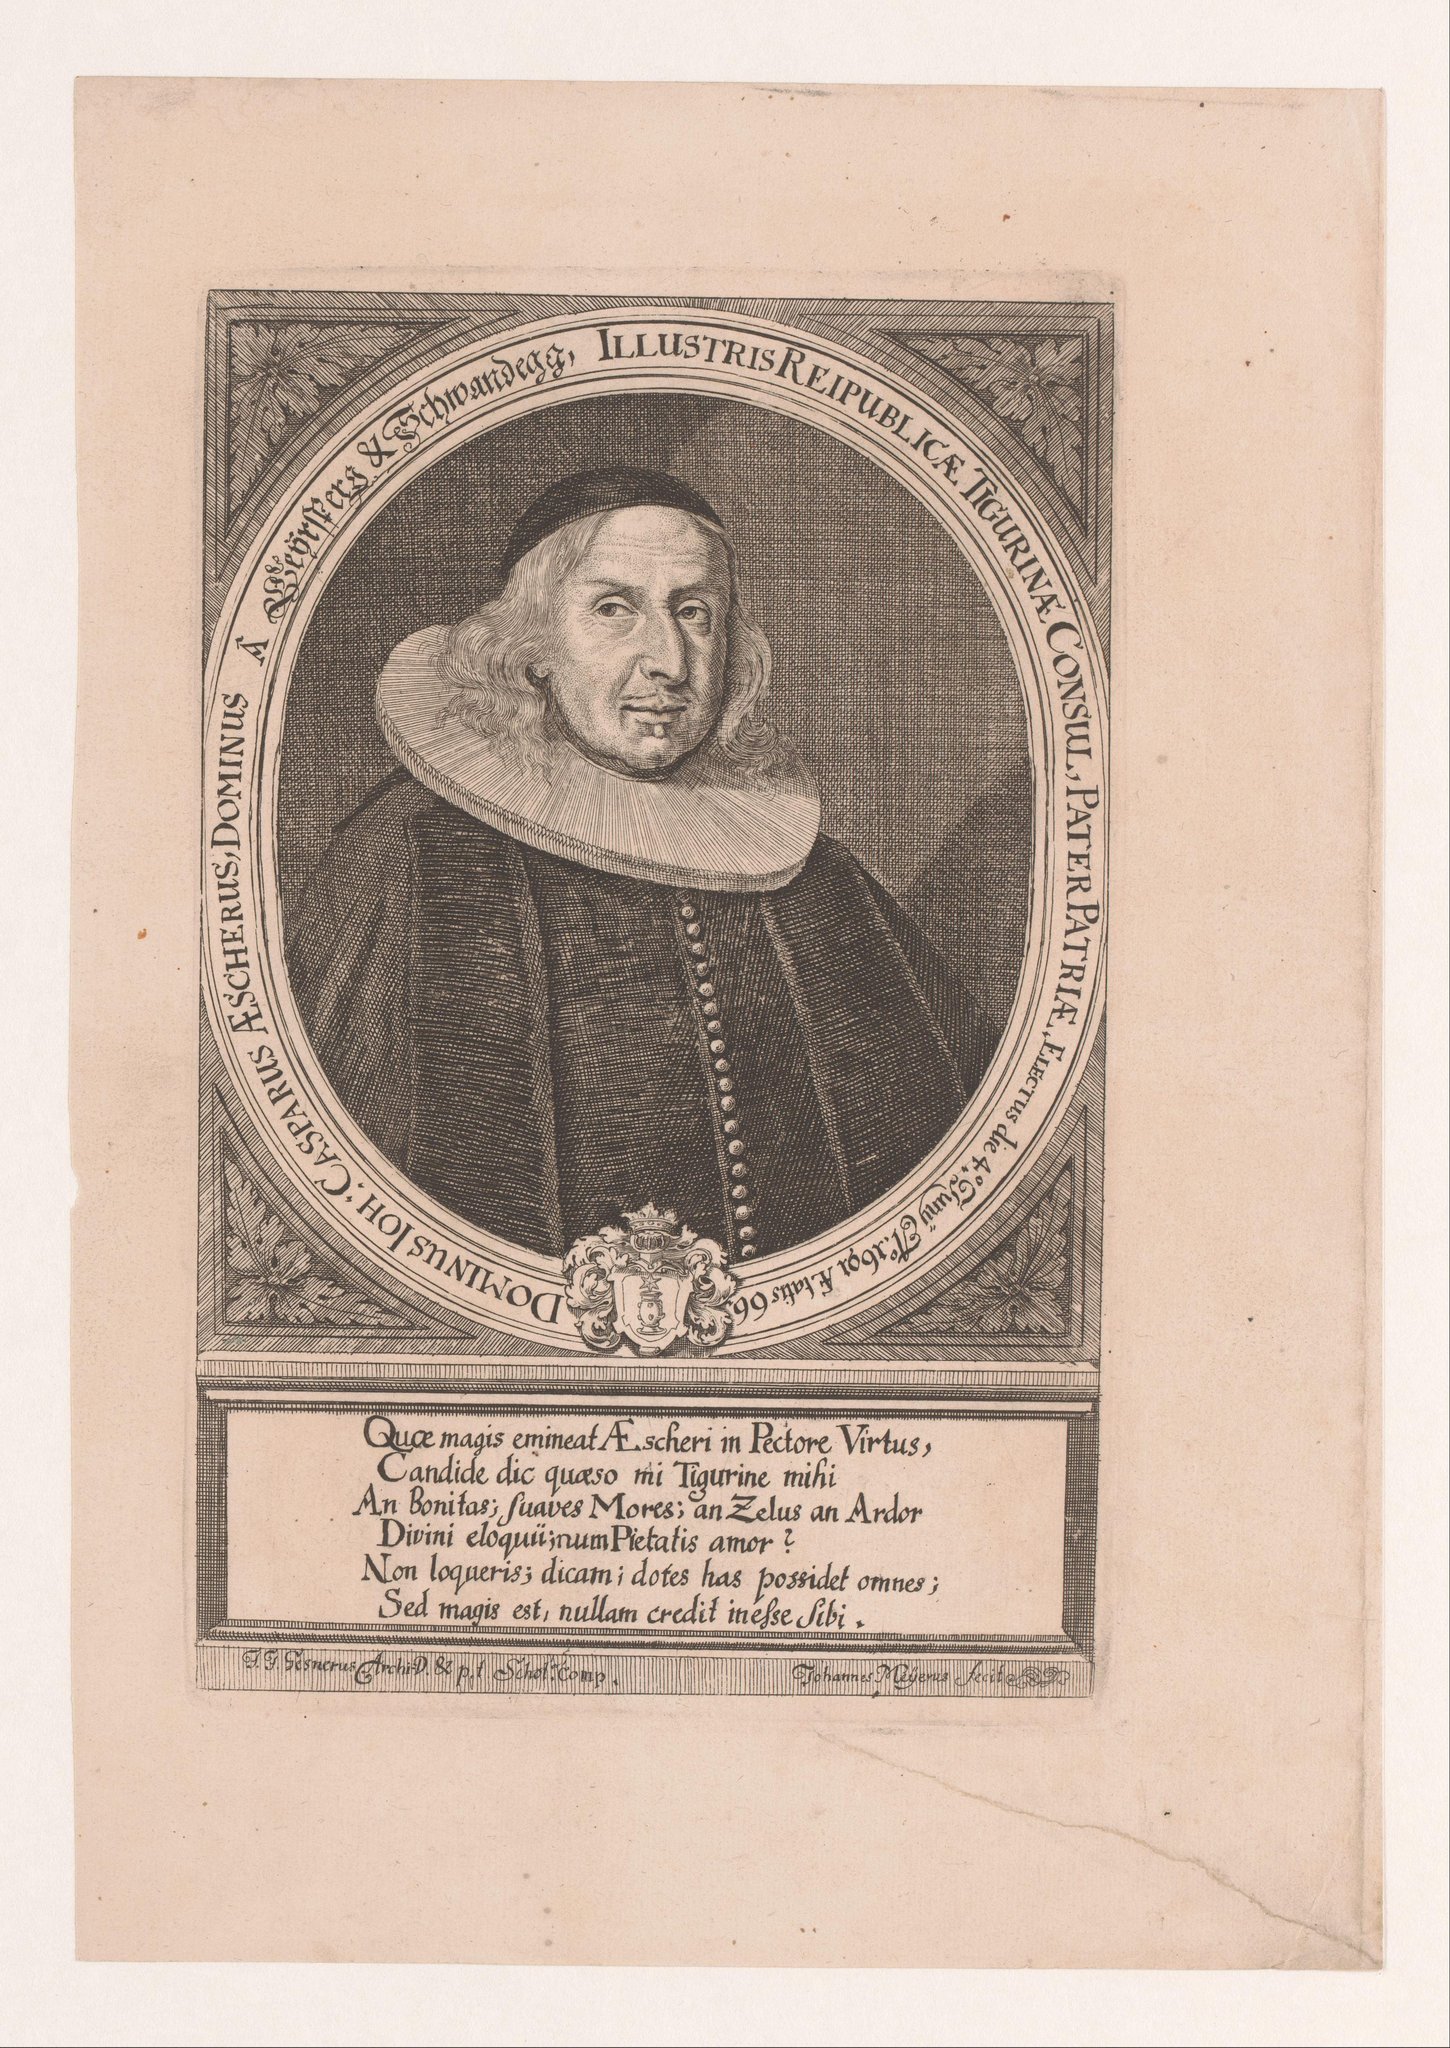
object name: print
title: Portret van Hans Caspar Escher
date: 1691-1712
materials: paper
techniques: engraving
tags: mayor, mayor, burgomaster, historical persons, armorial bearing, heraldry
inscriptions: collector's mark: Lugt 2228